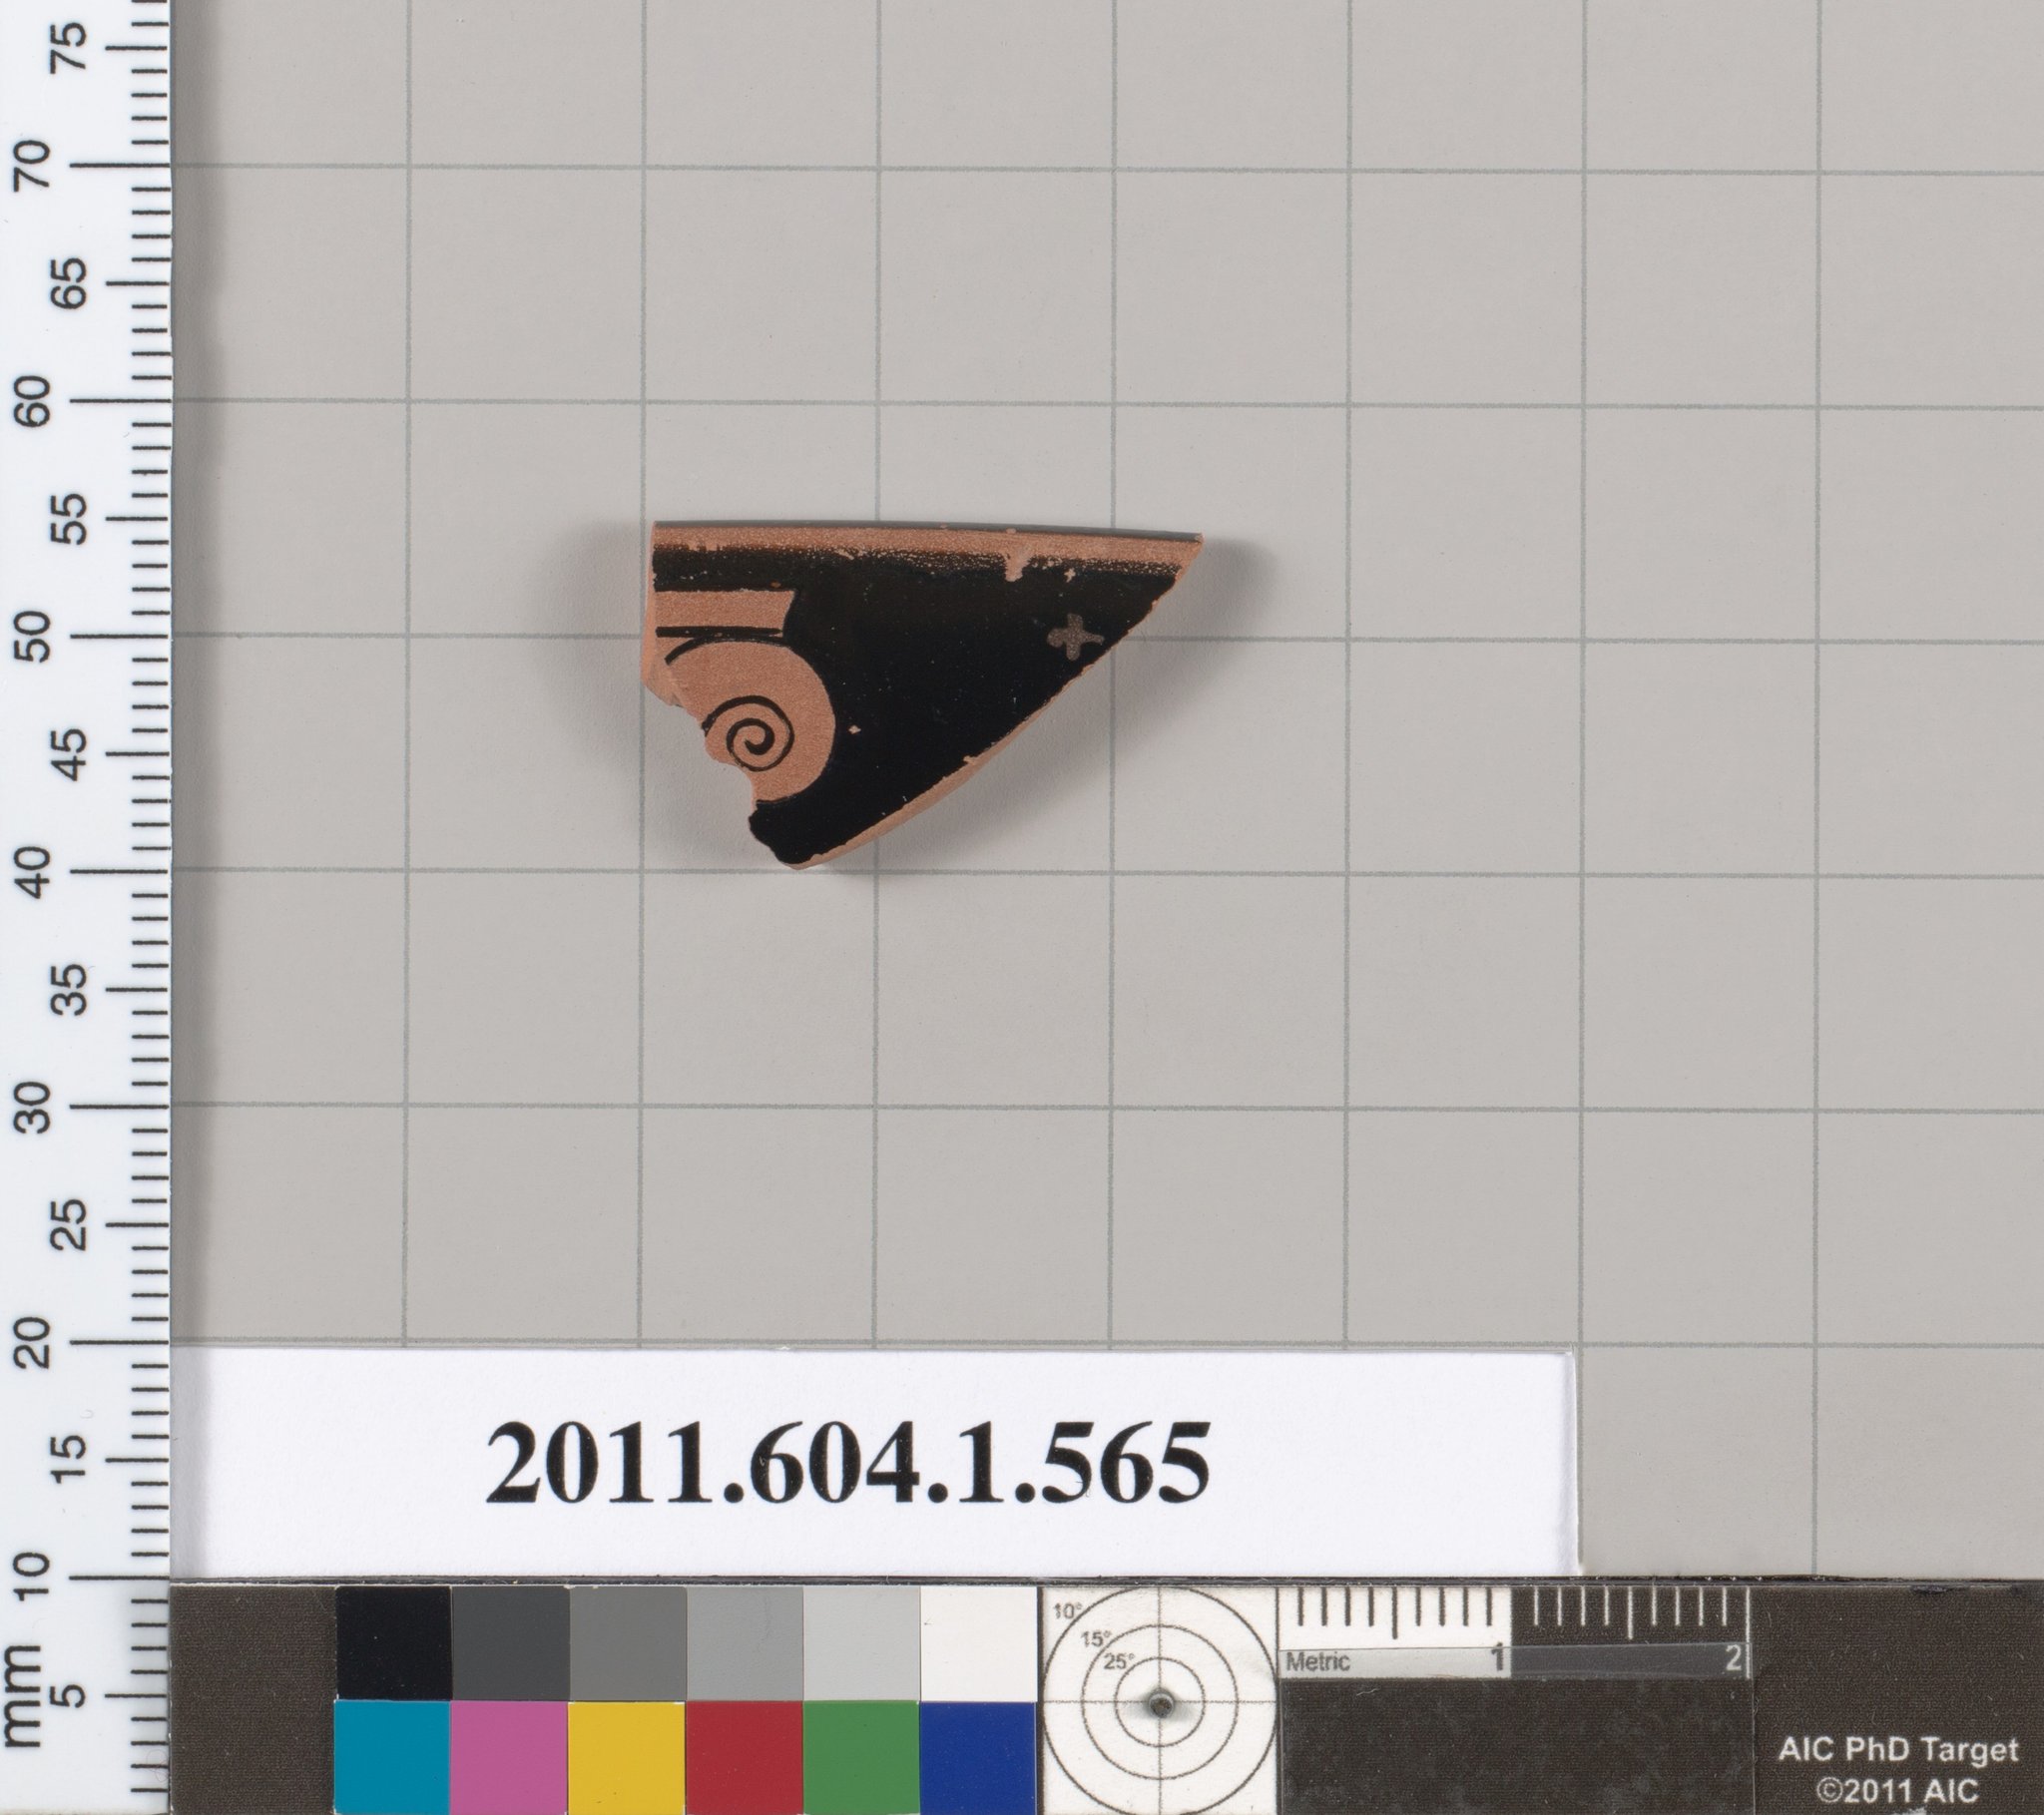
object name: kylix fragment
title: Terracotta rim fragment of a kylix (drinking cup)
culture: greek, attic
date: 480-470 BCE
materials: terracotta